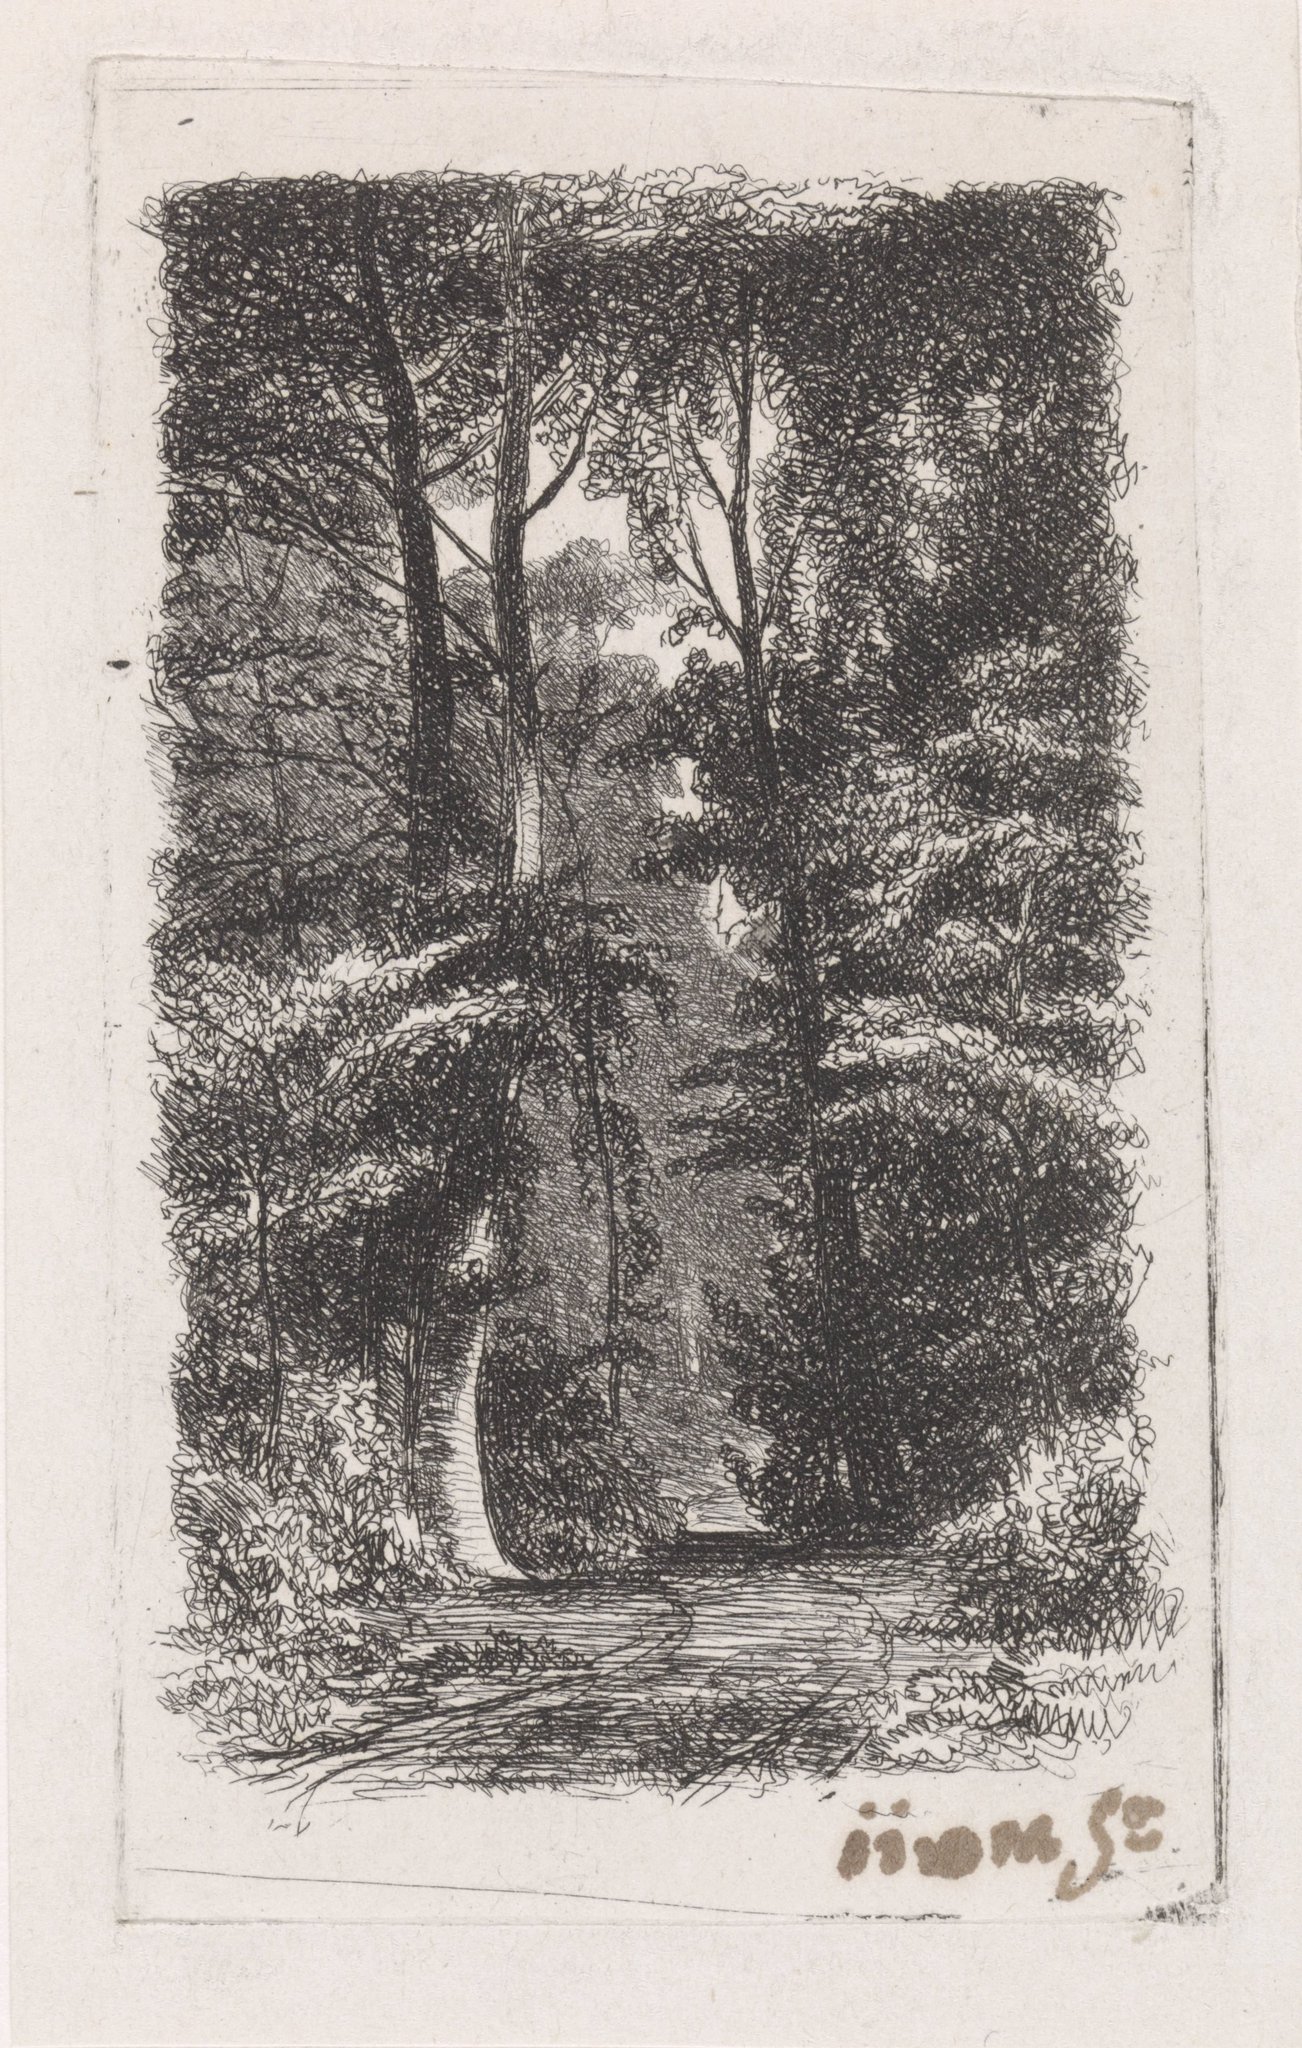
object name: print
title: Boslaan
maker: jacob jan van der maaten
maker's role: draughtsman, print maker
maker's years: 1820-1879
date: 1830-1879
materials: paper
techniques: etching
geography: netherlands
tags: forest path or lane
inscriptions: initials: ‘iivm f’, collector's mark: Lugt 2228